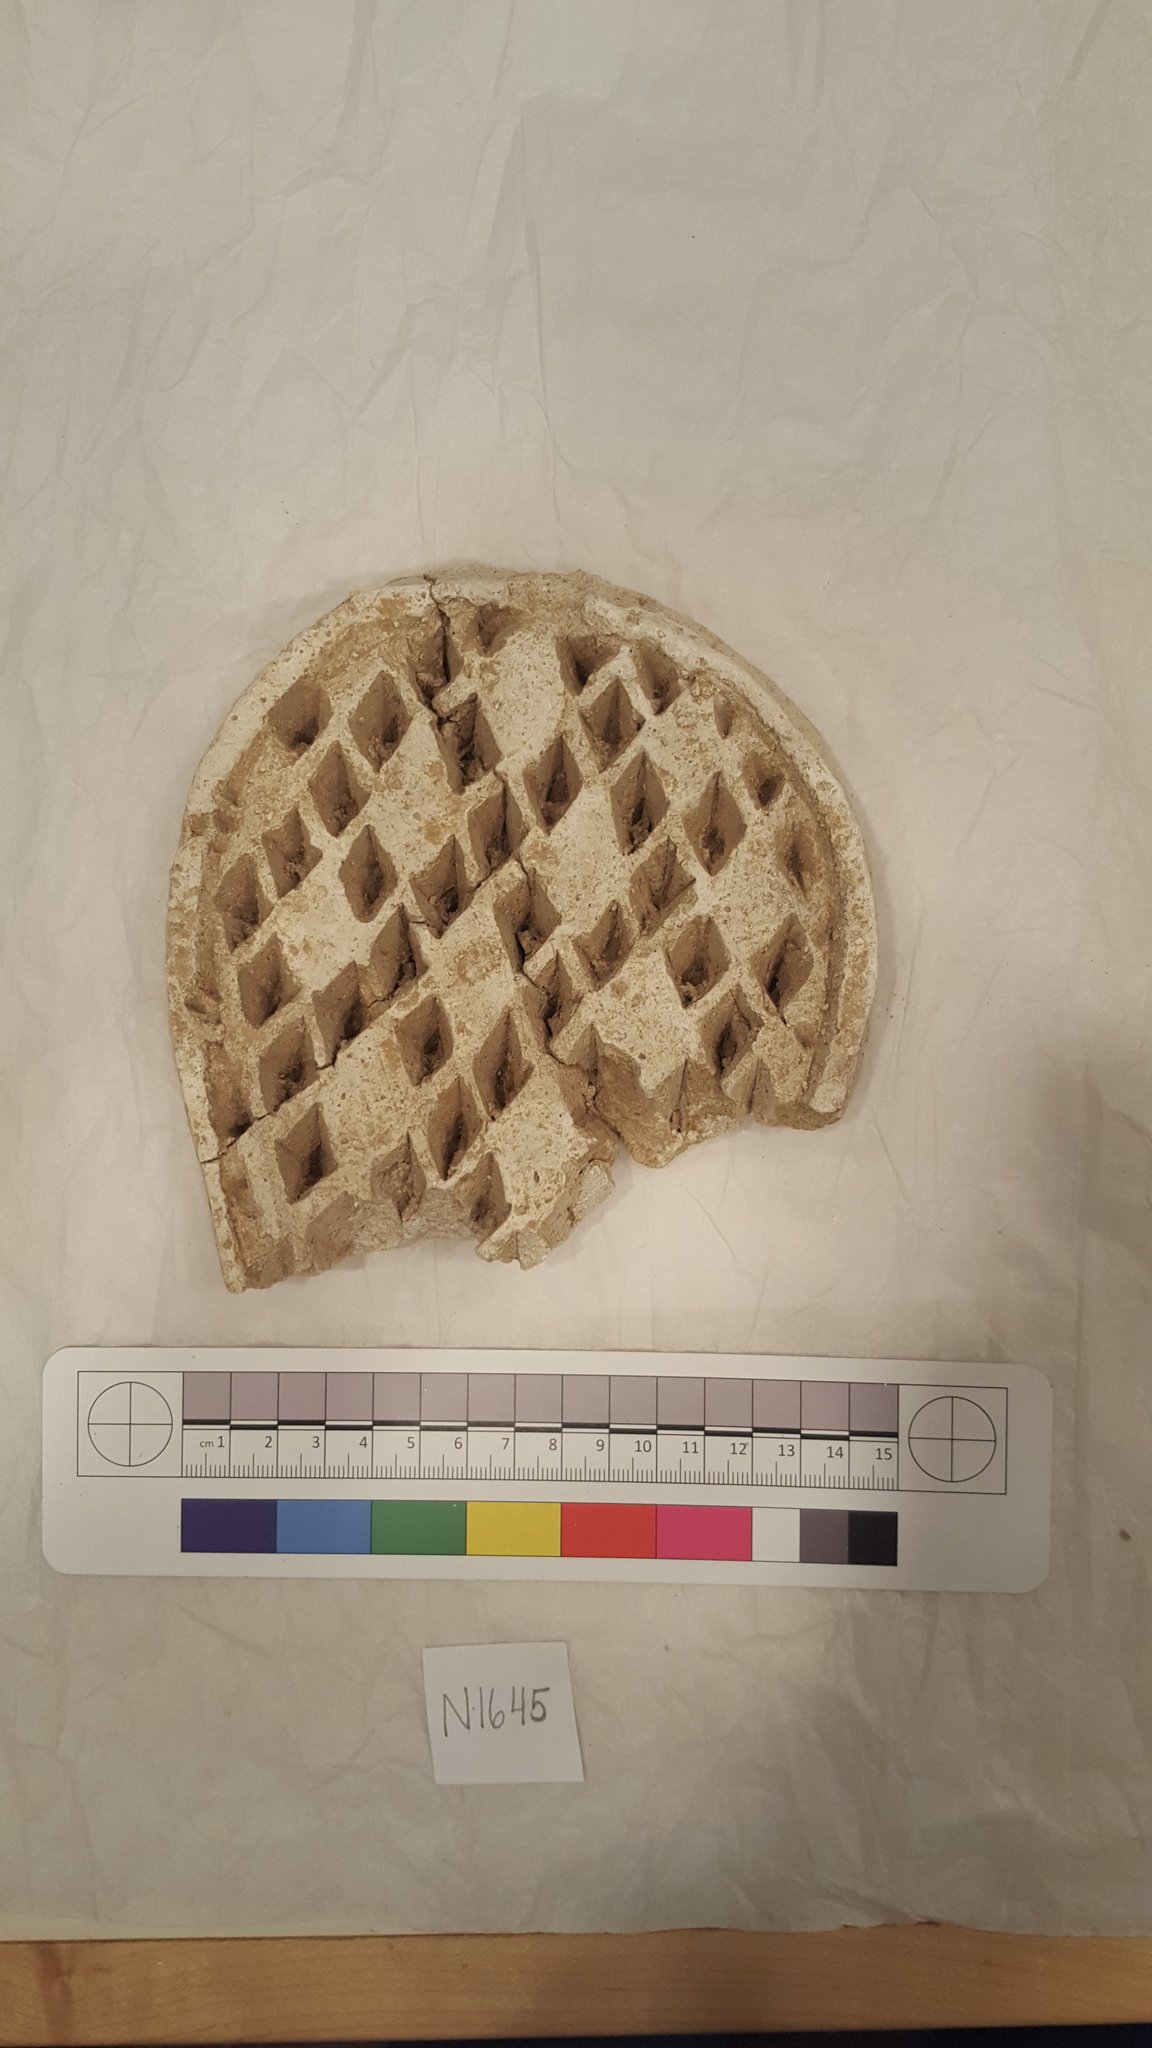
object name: fragment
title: Stucco Fragment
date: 701-1200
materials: plaster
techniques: carving, painting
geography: iran